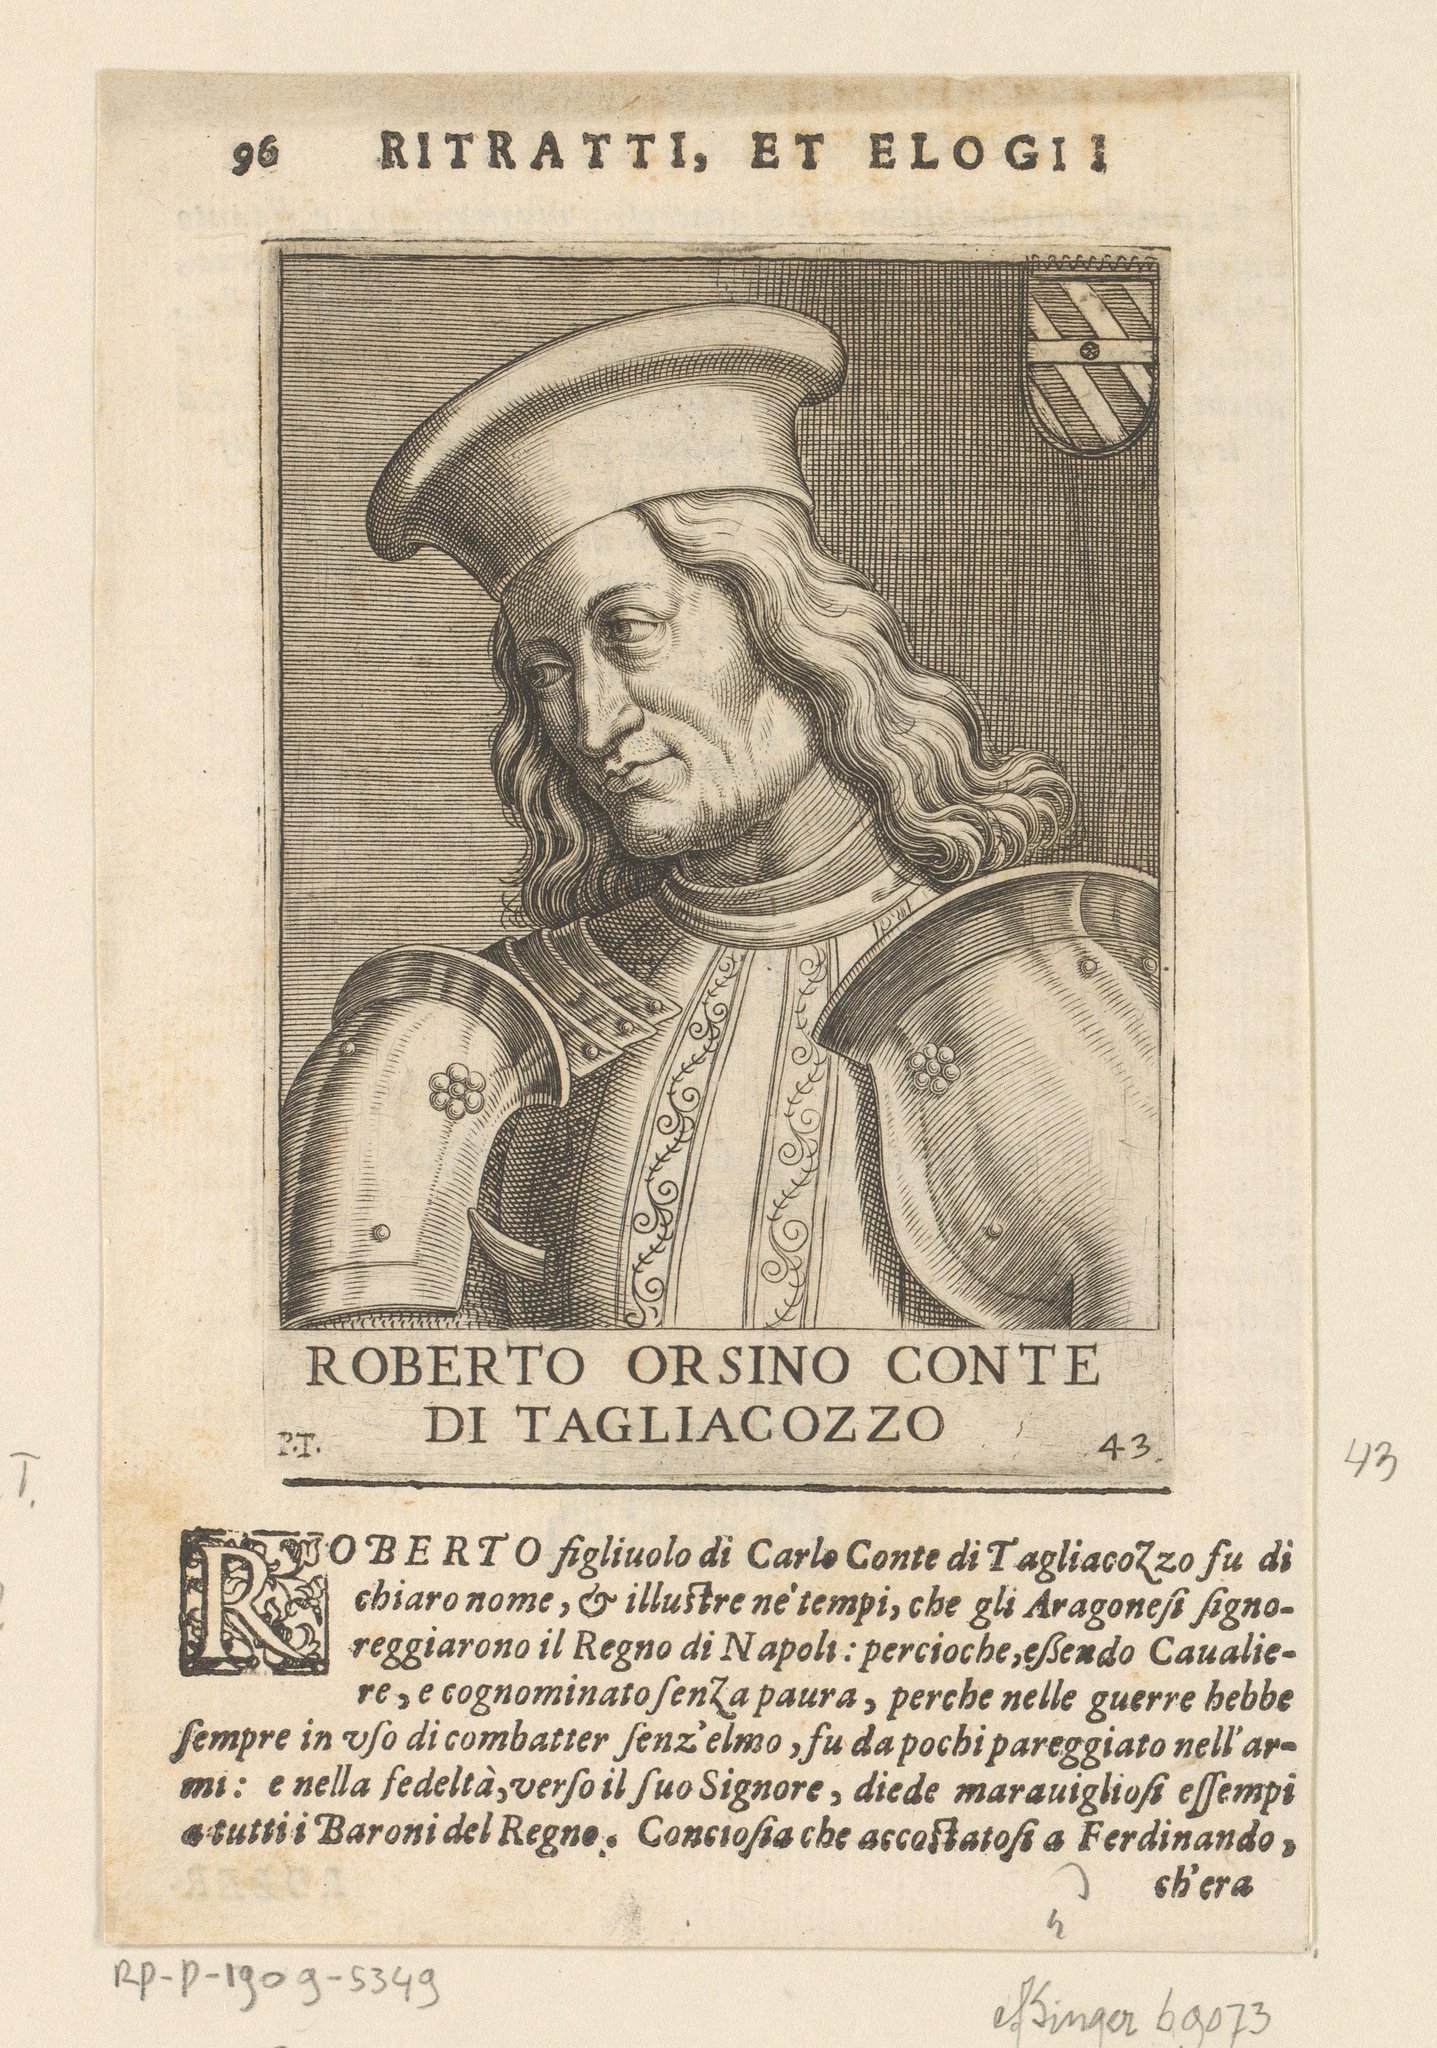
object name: print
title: Portret van Roberto Orsino, graaf van Tagliacozzo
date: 1635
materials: paper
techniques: engraving, letterpress printing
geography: rome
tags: earl, historical persons, ranks in the navy, armorial bearing, heraldry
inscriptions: collector's mark: Lugt 2228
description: Prent uit: Ritratti et elogii di capitani Illustri. Rome: Pompilio Totti en Andrea Fei, 1635, p. 96. Latere staat van prent in ieder geval ook gebruikt in: Ritratti et elogii di capitani Illustri. Che ne'secoli moderni hanno gloriosamente guerreggiato. Rome: Filippo de'Rossi en Vitale Mascardi, 1646.